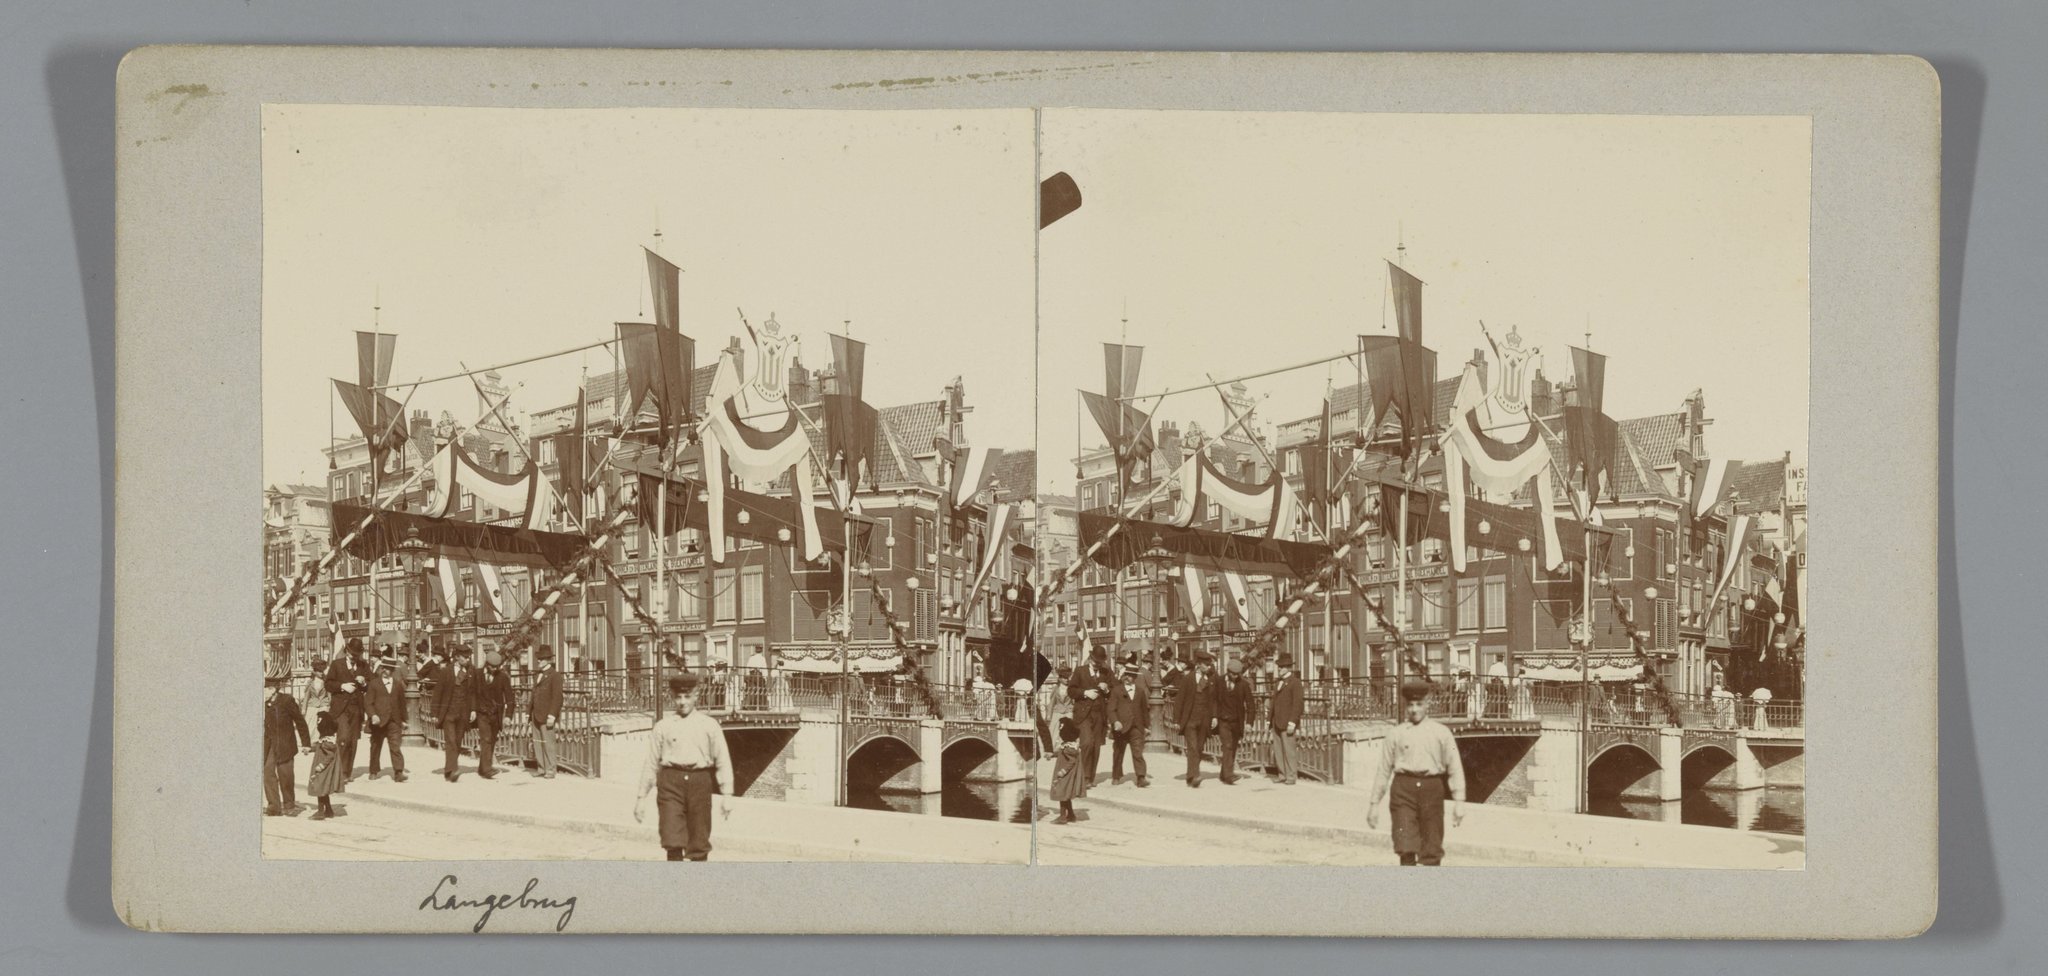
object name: stereograph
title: De Langebrug over het Rokin, versierd ter gelegenheid van de inhuldiging van koningin Wilhelmina, Amsterdam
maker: Anonymous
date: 1898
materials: paper, cardboard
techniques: gelatin silver print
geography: amsterdam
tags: the hague, print maker, wilhelmina of the netherlands, bridge in city across river, canal, etc., amsterdam